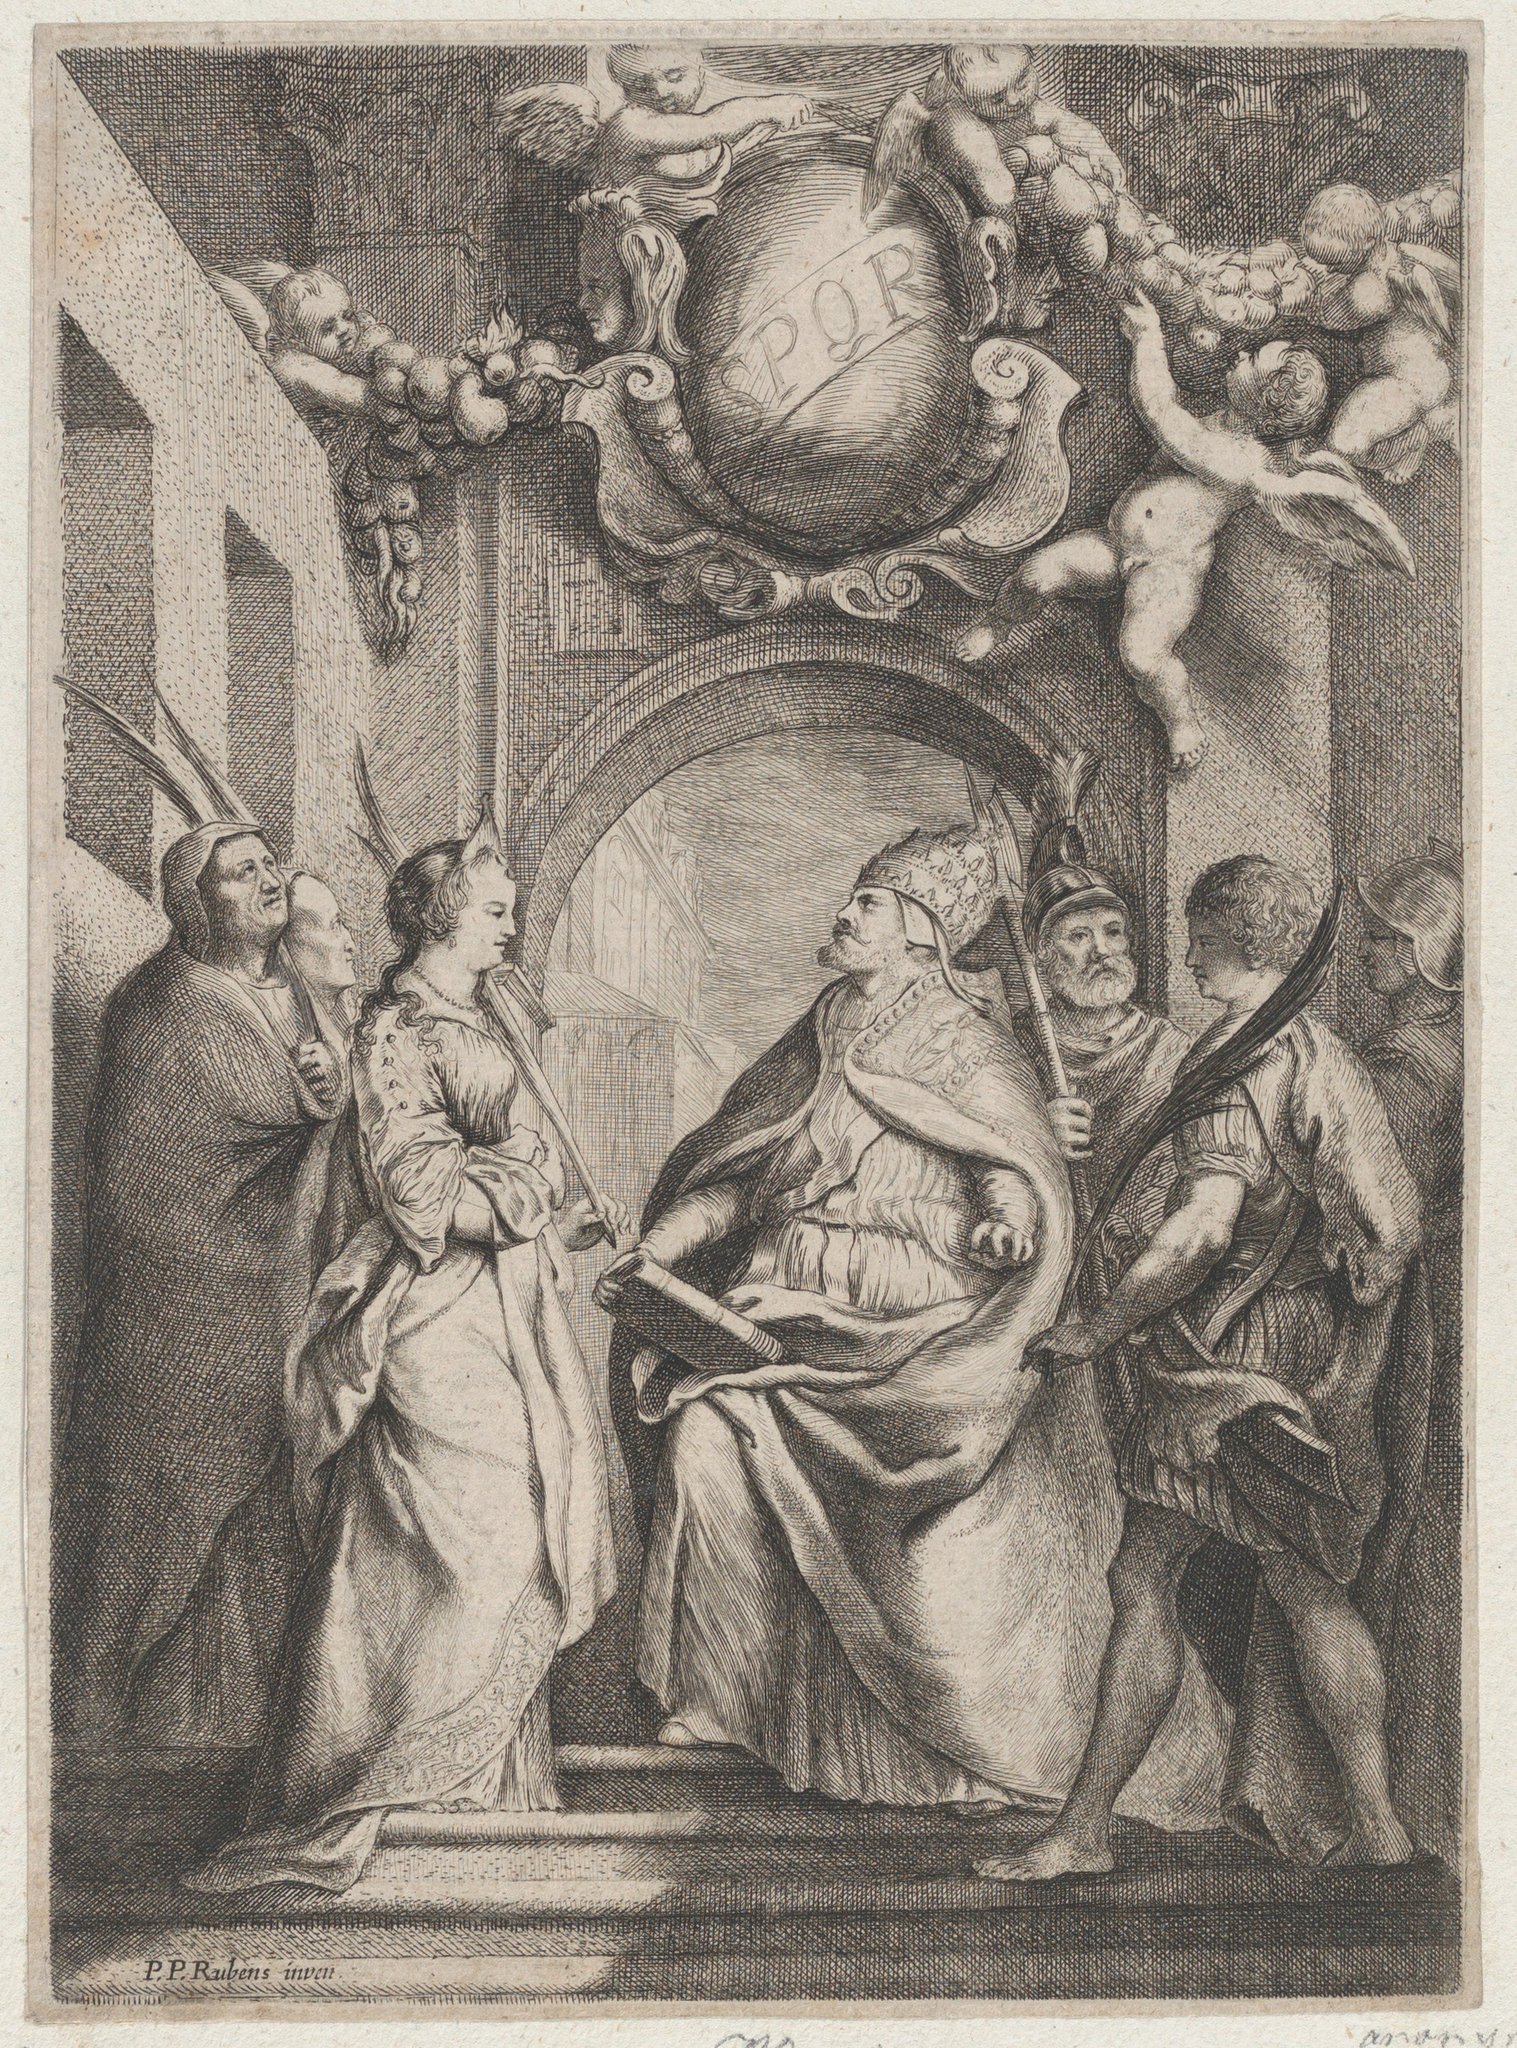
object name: print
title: Saint Gregory surrounded by other saints, in front of an archway with putti holding garlands overhead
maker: Anonymous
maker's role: artist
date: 1700-1750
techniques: etching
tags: men,women,saints,insignia